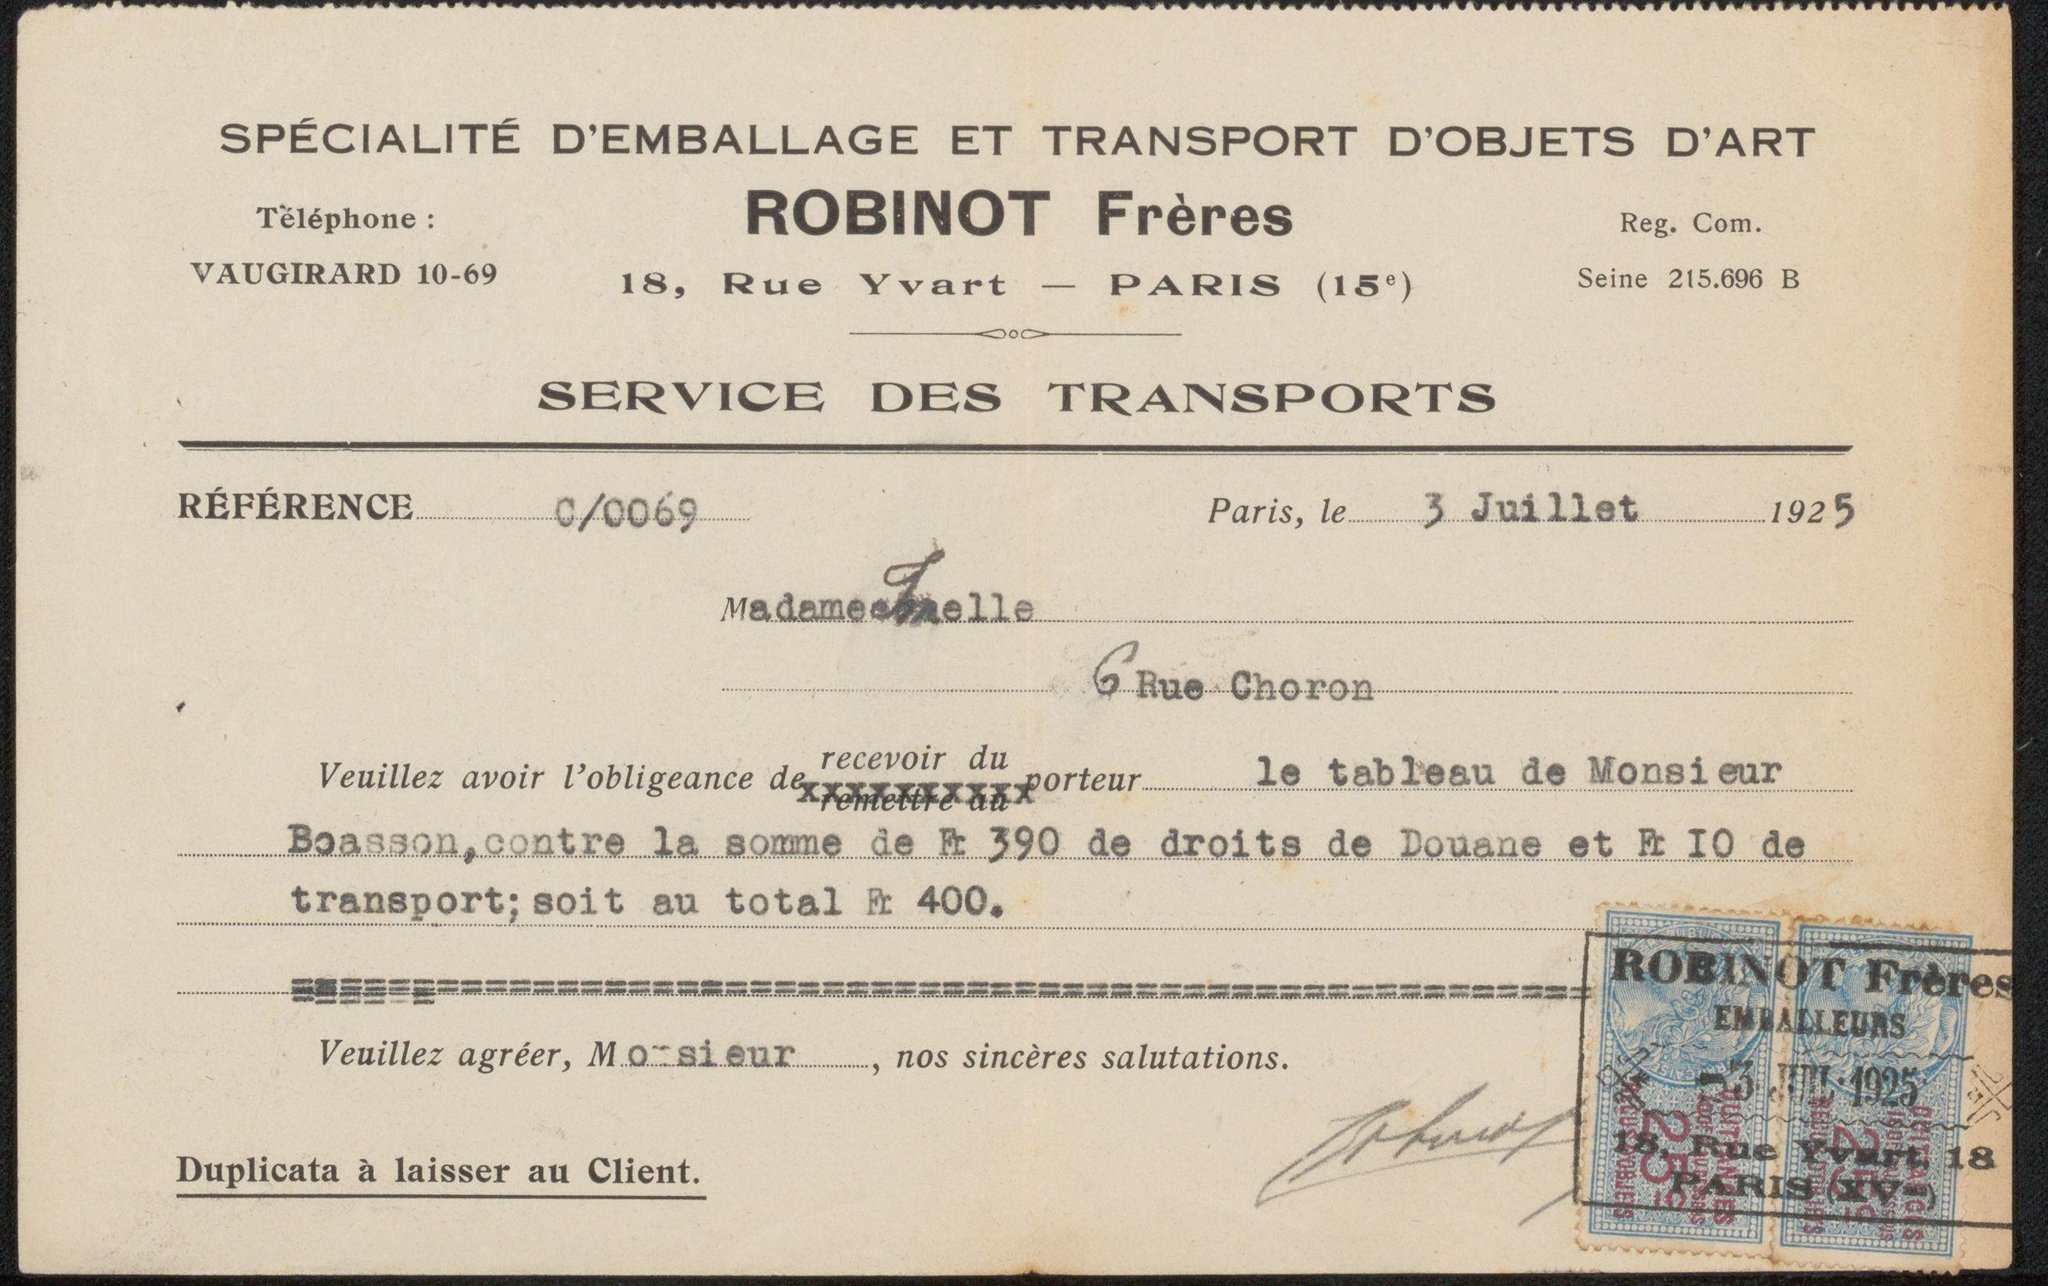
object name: document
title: Transportbon aan Rose Imel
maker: rose imel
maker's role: draughtsman, painter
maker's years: 1901-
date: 1925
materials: paper, pencil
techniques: printing, writing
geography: paris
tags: middelburg, paris, print maker, isodoor boasson, rose imel, painter, draughtsman, philip zilcken, painting (including book-illumination, miniature-painting)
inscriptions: collector's mark: ‘RPK’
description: Verso een aantekening van Rose Imel aan Philip Zilcken.